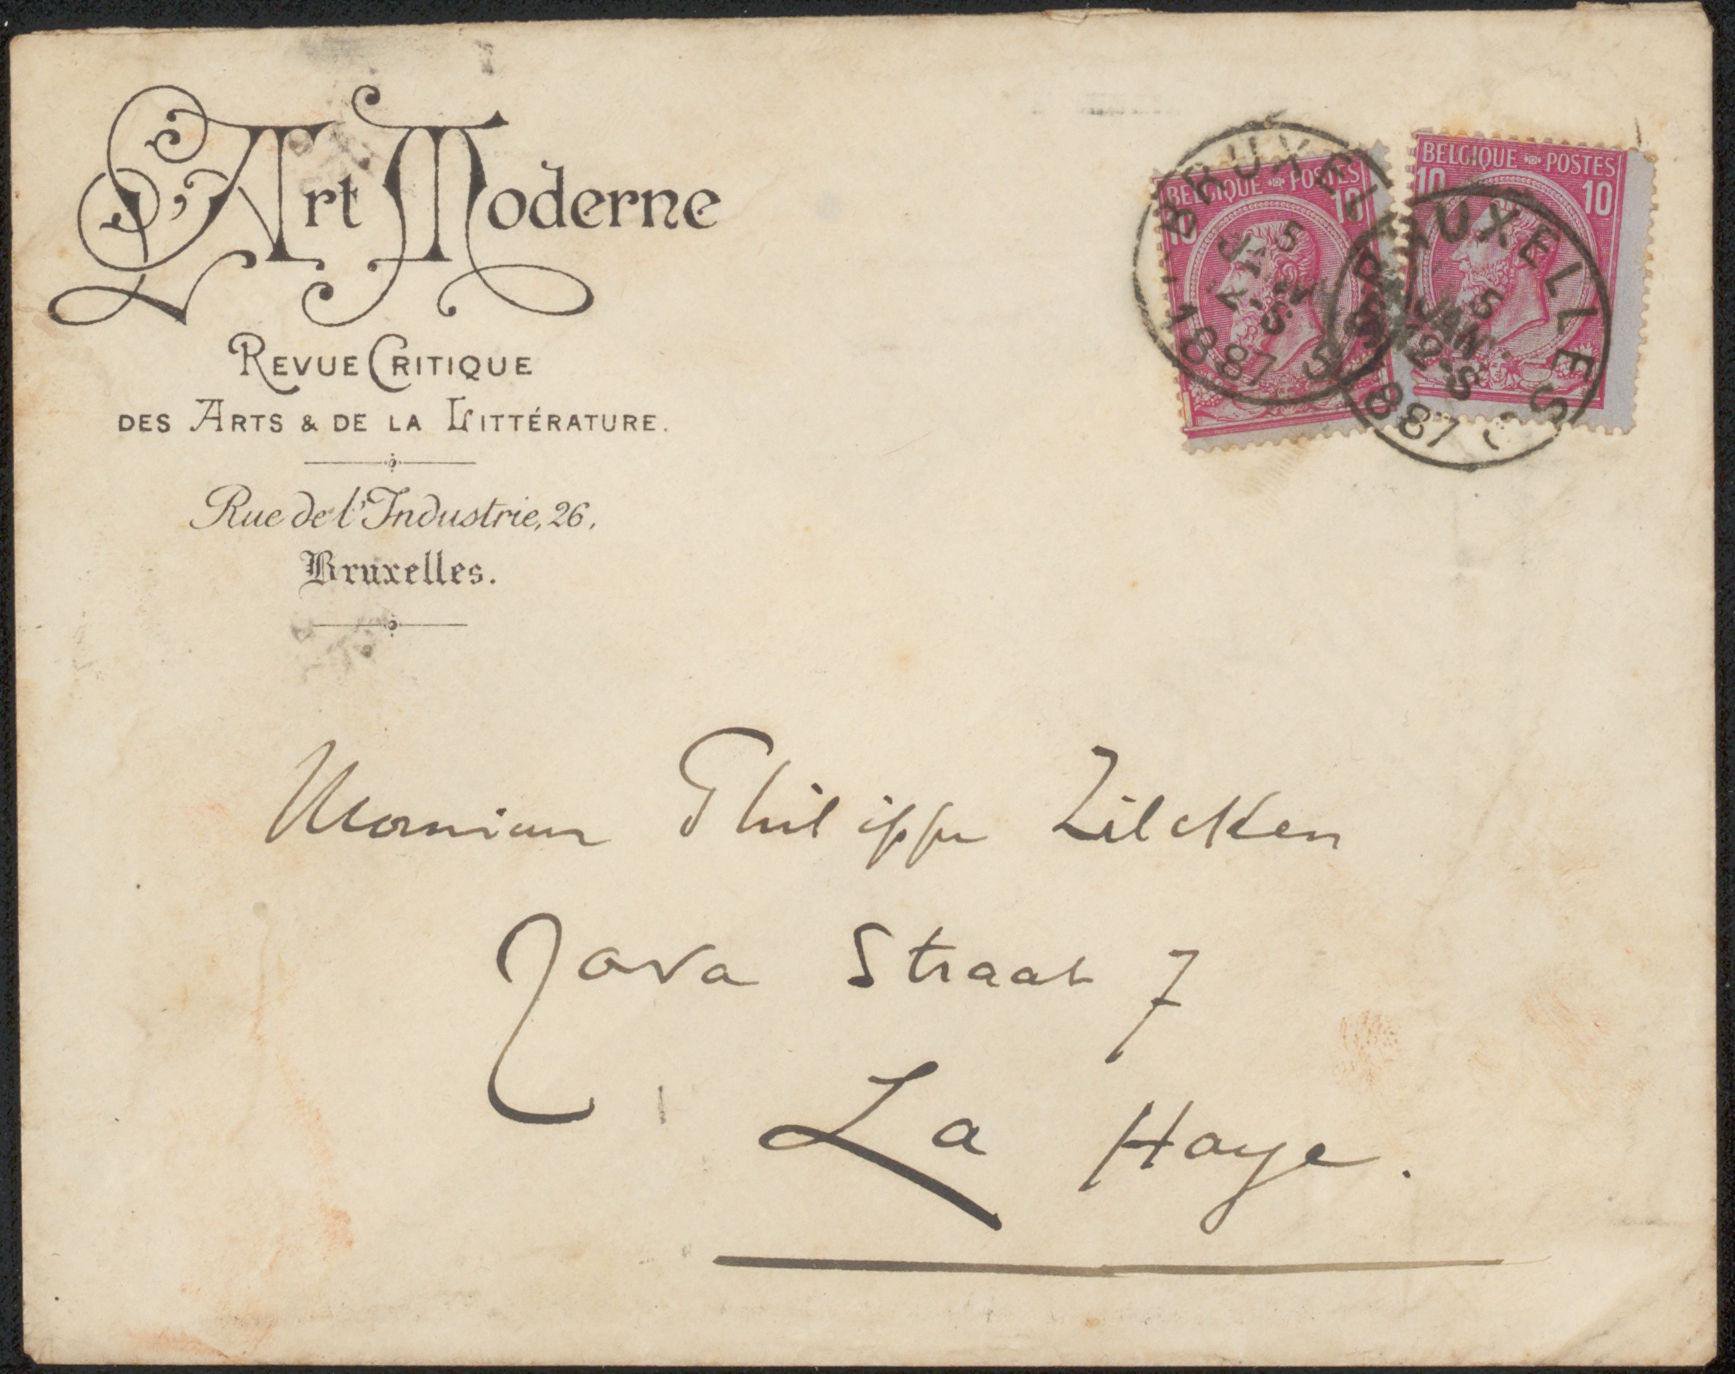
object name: envelope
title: Envelop aan Philip Zilcken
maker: octave maus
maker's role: painter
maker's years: 1856-1919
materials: ink, paper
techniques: pen, printing, writing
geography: brussels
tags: the hague, painter, draughtsman, philip zilcken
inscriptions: collector's mark: ‘RPK’